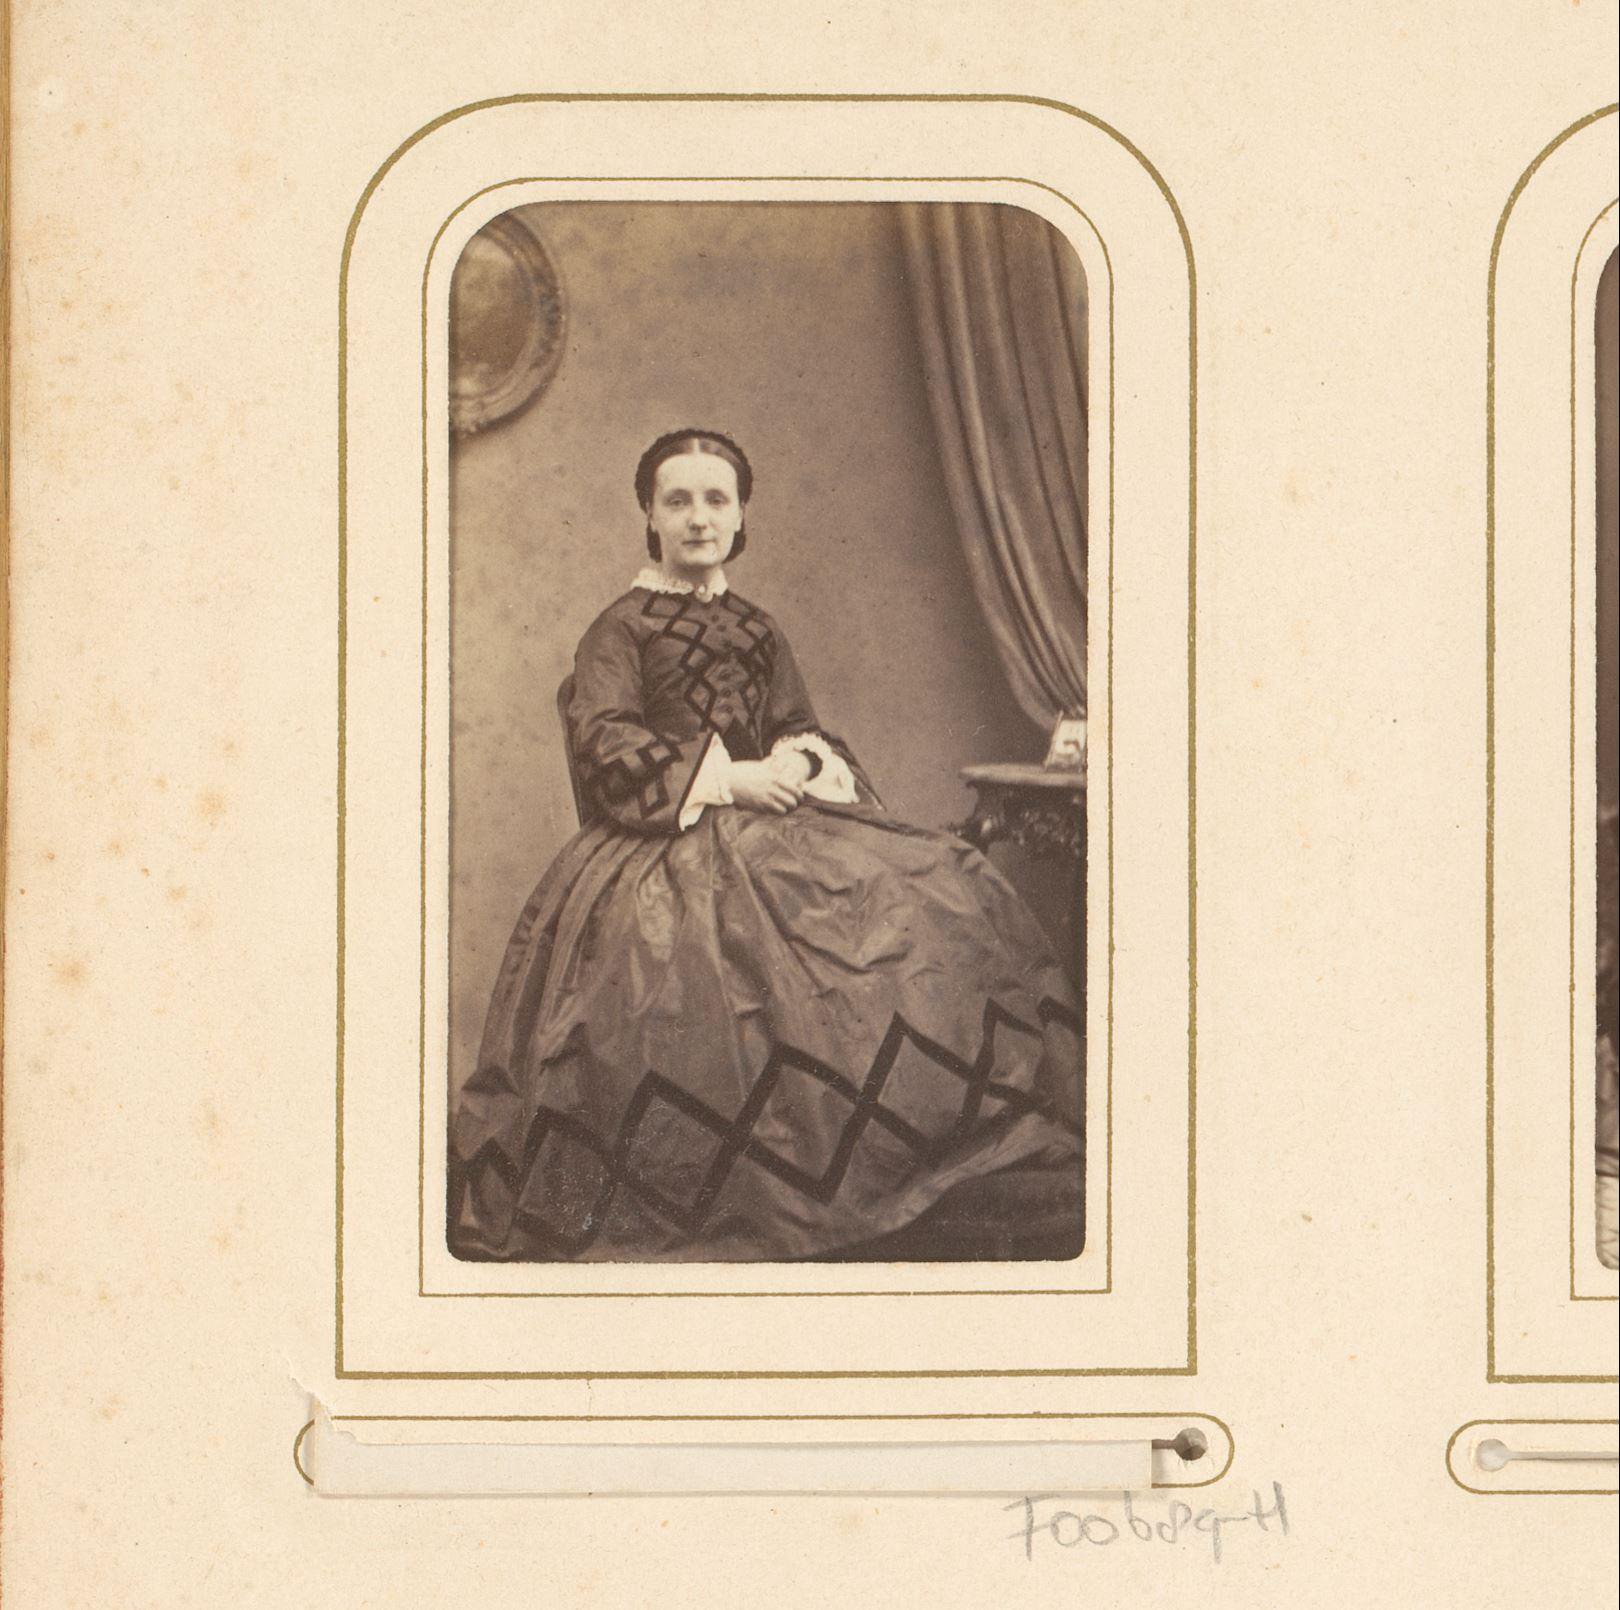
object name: album leaf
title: Portret van A.J. Bijleveld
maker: maurits verveer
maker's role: painter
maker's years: 1817-1903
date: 1863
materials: cardboard, photographic support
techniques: albumen print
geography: the hague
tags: historical persons - bb - woman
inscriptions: inscription: ‘M. Verveer/ Photographe/ 46, Zeestraat, 46/ vis a vis du Willemspark/ La Haye’, annotation: ‘il votre affectionnée/ J. Bijleveld/ 1863’